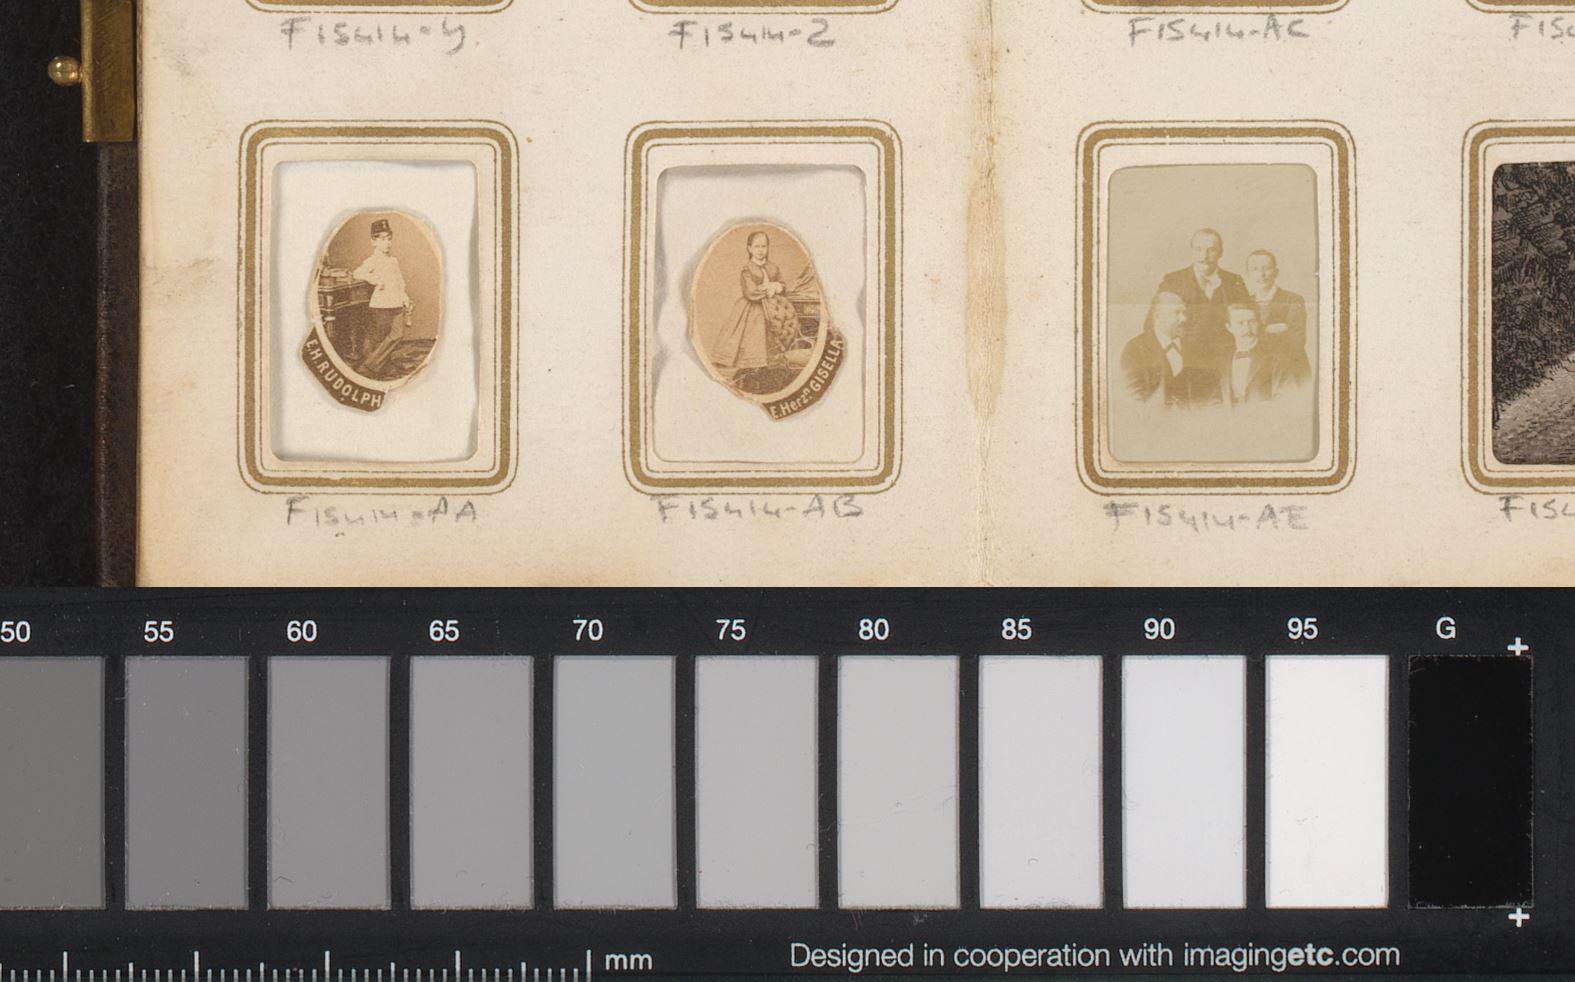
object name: photograph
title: E.Herz(n) Gisela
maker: Anonymous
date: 1856-1900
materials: paper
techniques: albumen print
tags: nobility and patriciate; chivalry, knighthood